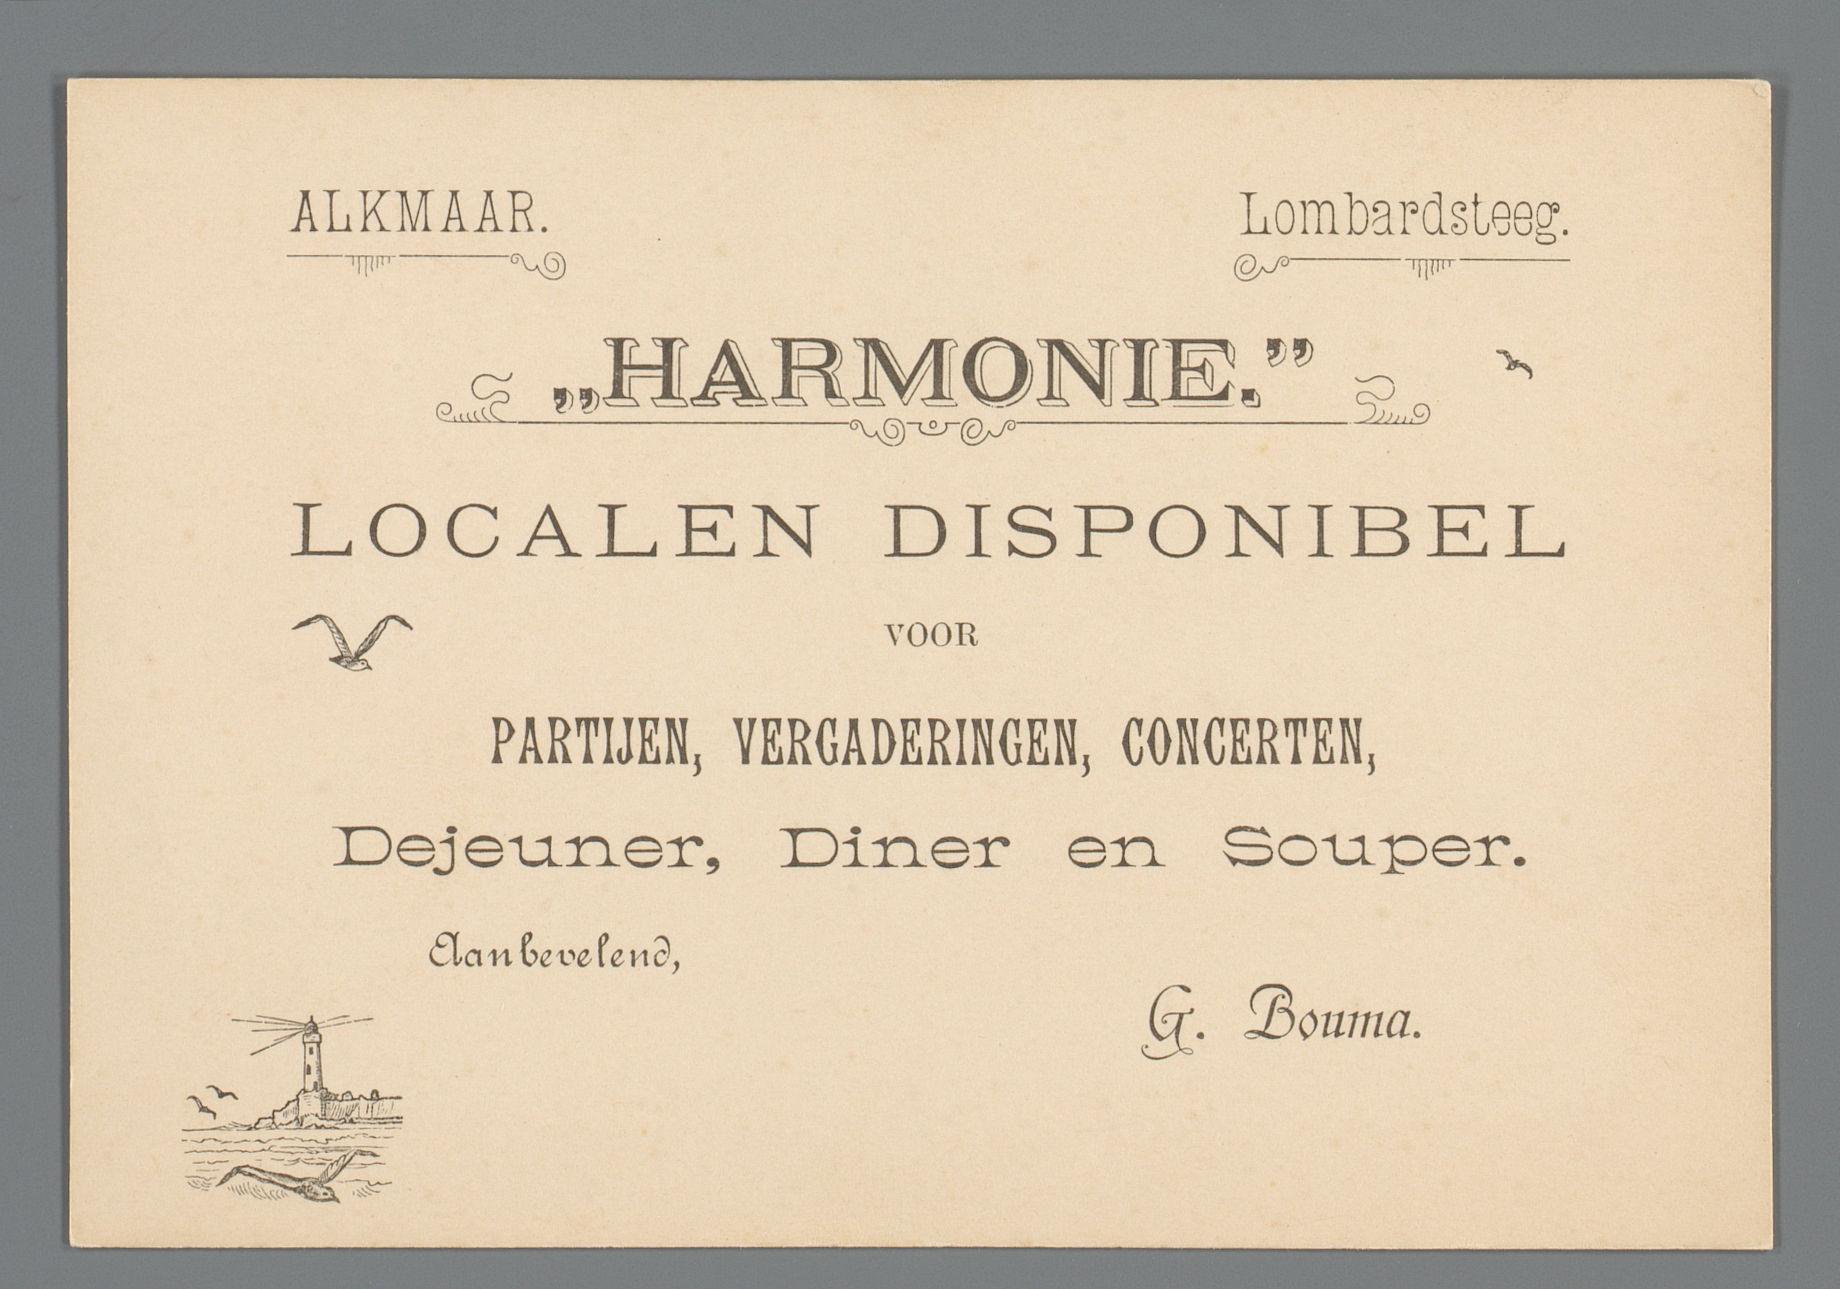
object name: visiting card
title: Visitekaart van zaalverhuur 'Harmonie' in Alkmaar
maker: Anonymous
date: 1865-1890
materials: paper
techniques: letterpress printing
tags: visiting-card, calling-card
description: Typografische kaart met de tekst: ''Harmonie.' Localen disponibel voor partijen, vergaderingen, concerten, Dejeuner, Diner en Souper. Aanbevelend, G. Bouma'. Linksonder een klein vignet van een vuurtoren aan de kust.